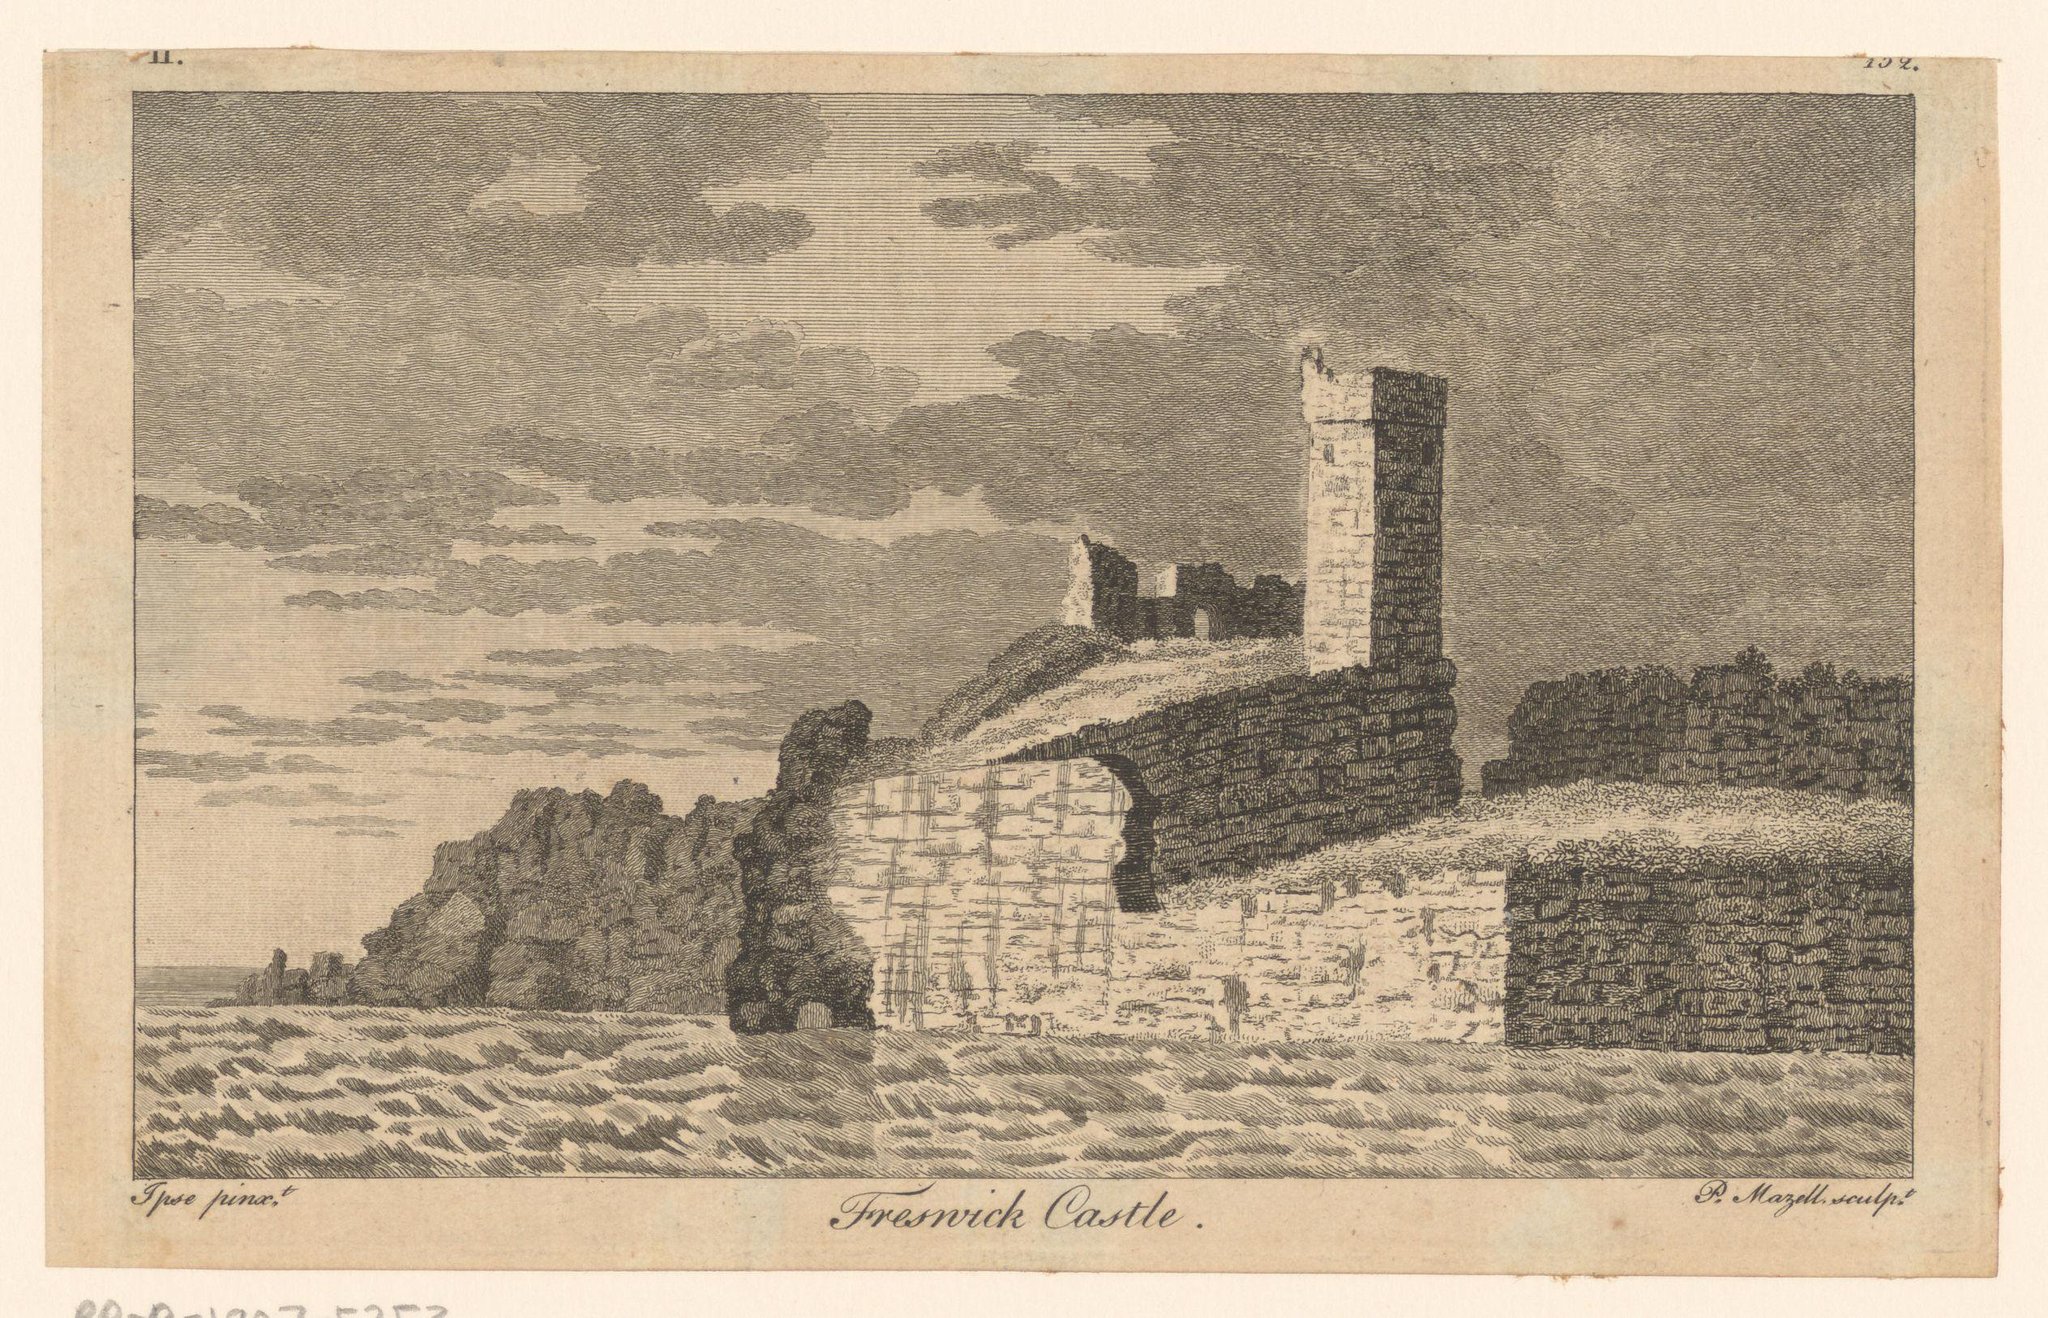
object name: book illustration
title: Freswick Castle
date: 1772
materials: paper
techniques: etching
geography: london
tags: rocky coast, landscape with tower or castle, ruin of a dwelling, house, castle, etc.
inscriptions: collector's mark: Lugt 2228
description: Prent uit: Pennant, Thomas. A tour in Scotland. Londen: Benjamin White, 1772.